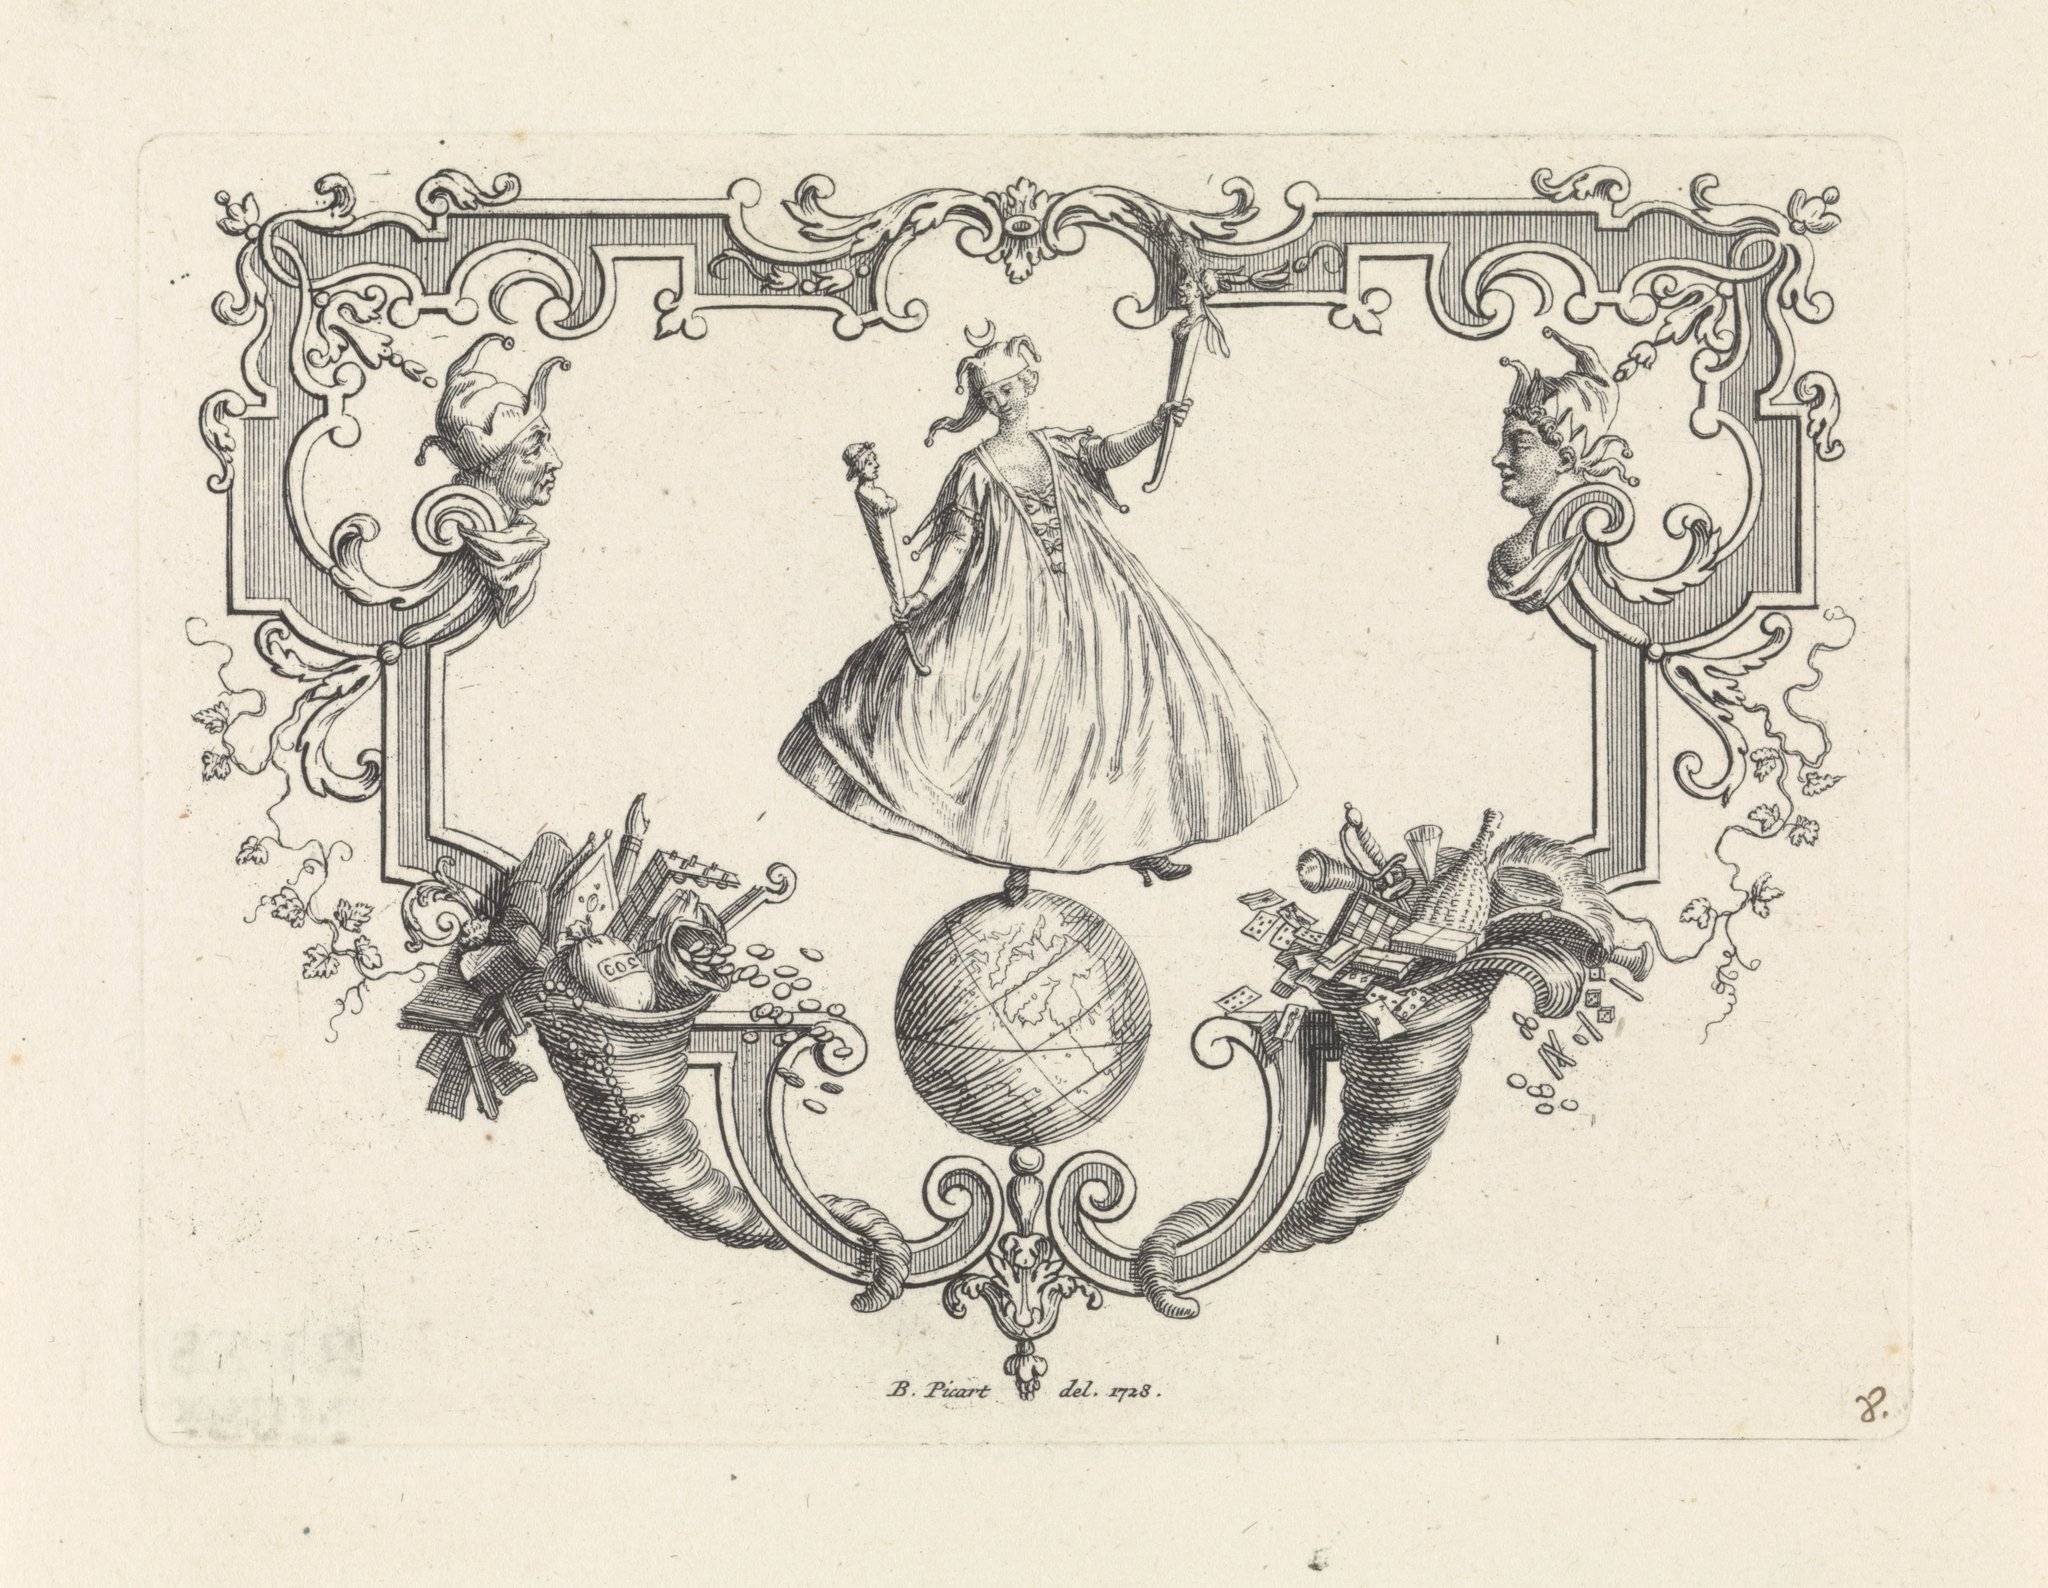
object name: print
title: Dwaasheid dansend op de wereld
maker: bernard picart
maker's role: draughtsman, print maker, publisher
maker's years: 1673-1733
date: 1728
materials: paper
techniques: engraving, etching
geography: amsterdam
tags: 'cornucopia', horn of plenty, ornaments ~ art, bauble, folly, foolishness; 'pazzia', 'sciocchezza', 'stoltitia' (ripa)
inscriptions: number: ‘8.’, collector's mark: Lugt 2165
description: De personificatie van de dwaasheid danst met zotskolven in haar handen op de wereldbol. Aan weerszijden van haar hoornen des overvloeds, gevuld met wereldse dingen, zoals speelkaarten, geld en muziekinstrumenten. De voorstelling is gevat in een ornamentele omlijsting van bladranken, rolwerk, twee zotskoppen.